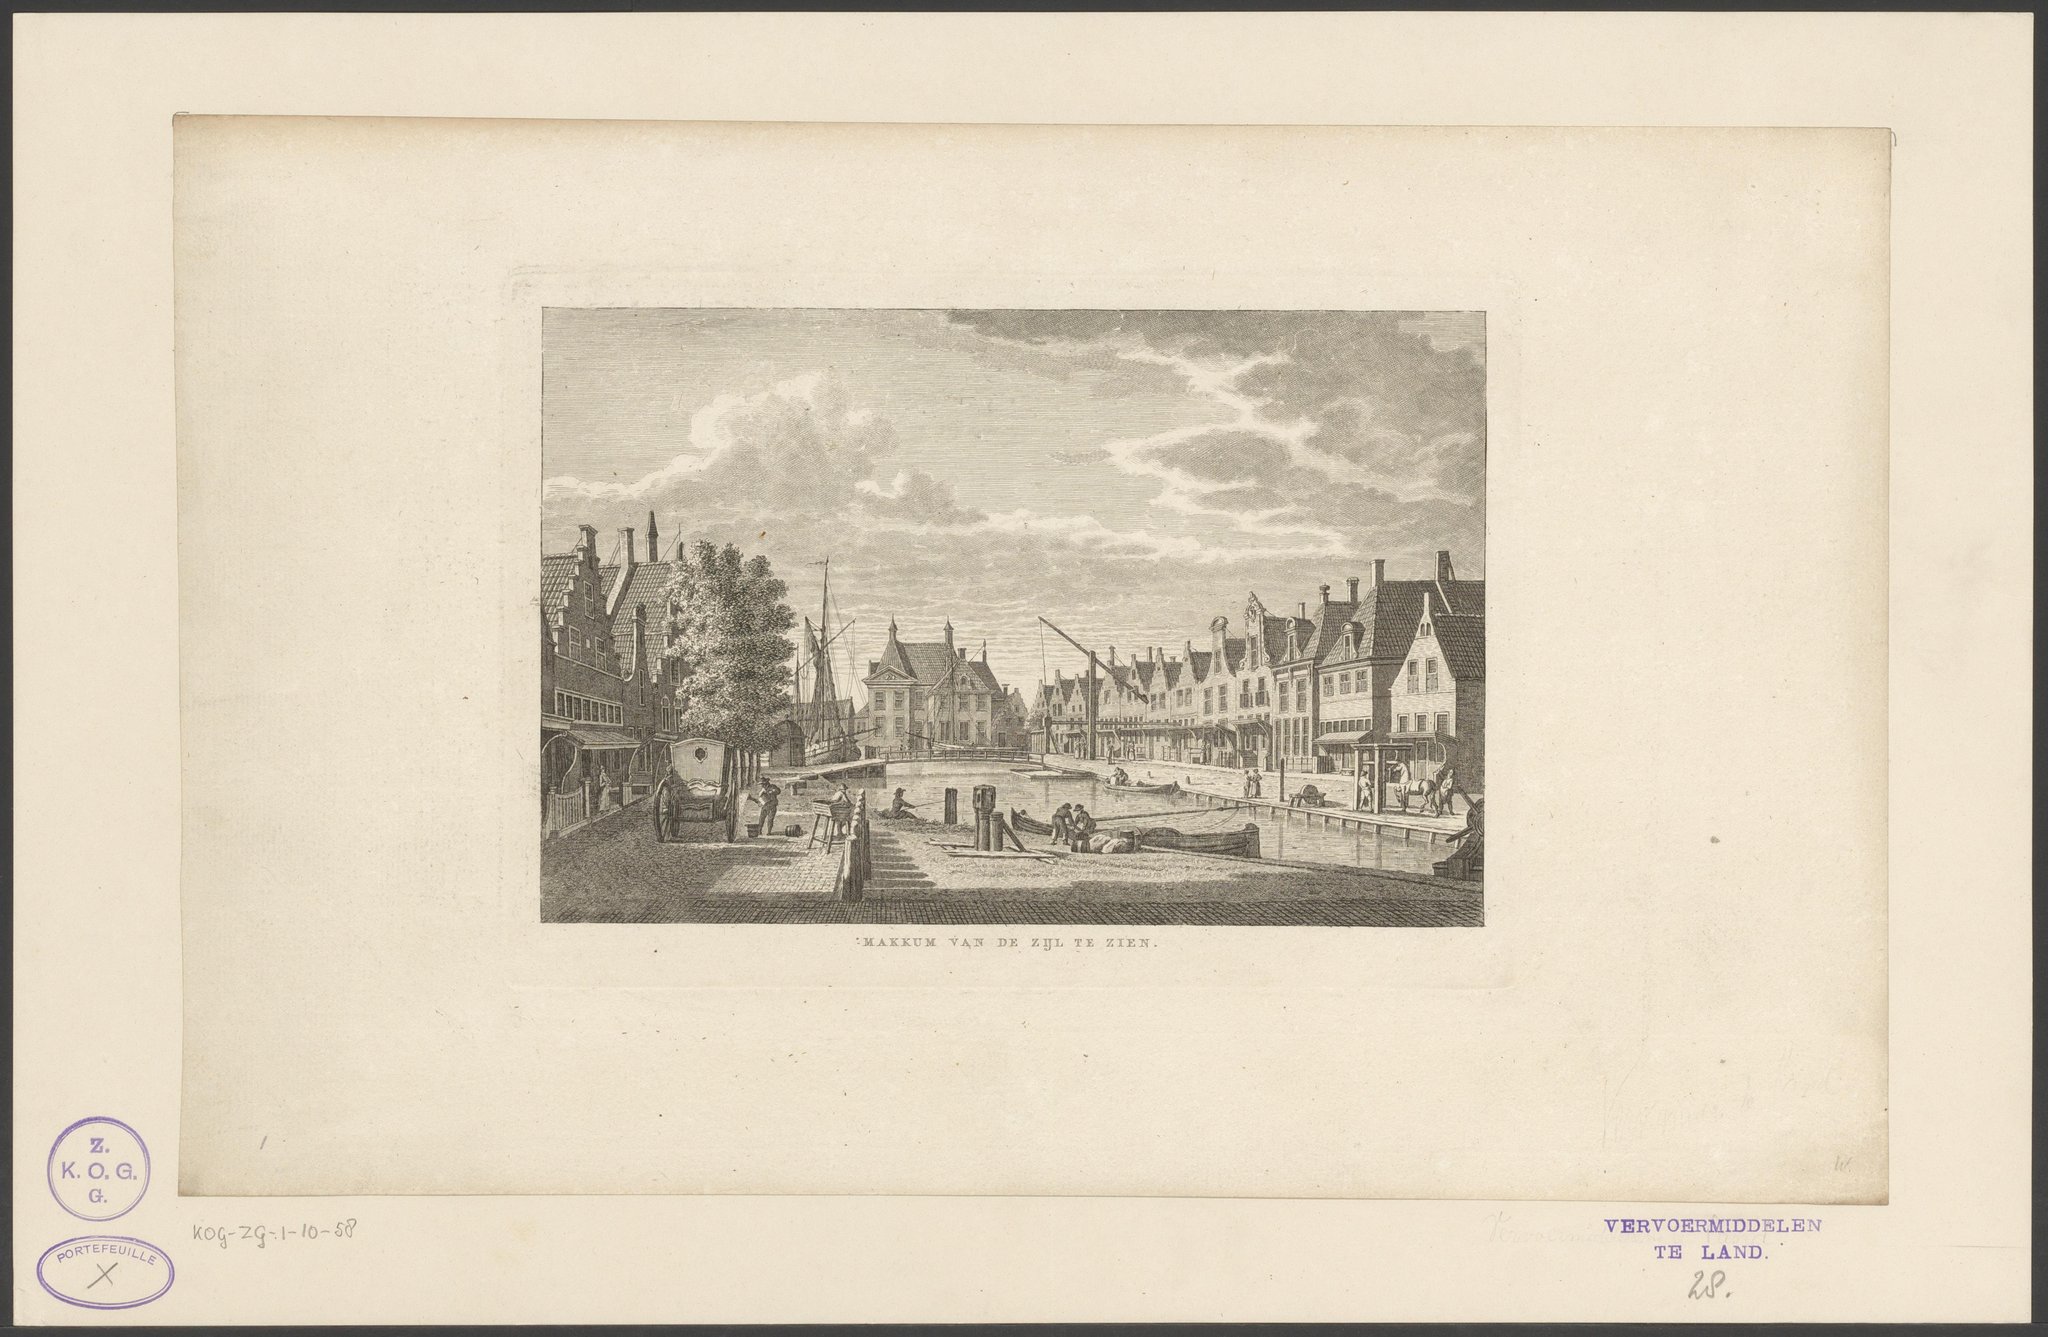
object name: print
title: Gezicht op Makkum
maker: jan bulthuis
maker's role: draughtsman, print maker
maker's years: 1750-1801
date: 1786-1792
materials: paper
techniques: etching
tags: four-wheeled, animal-drawn vehicle, e.g.: cab, carriage, coach, canal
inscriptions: collector's mark: Lugt 1641, stamp, stamp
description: Prent uit: Vaderlandsche gezichten, of afbeeldingen van den tegenwoordigen staat der Vereenigde Nederlanden (…). Amsterdam: Hendrik Gartman, Willem Vermandel en Jan Willem Smit, 1786-1792. Uitgegeven in afleveringen met ieder een eigen bifolium en inhoudsopgave. Alle prenten in deze publicatie zijn gegraveerd door Carel Frederik Bendorp (I) en, in de meeste gevallen, gebaseerd op tekeningen van Jan Bulthuis.